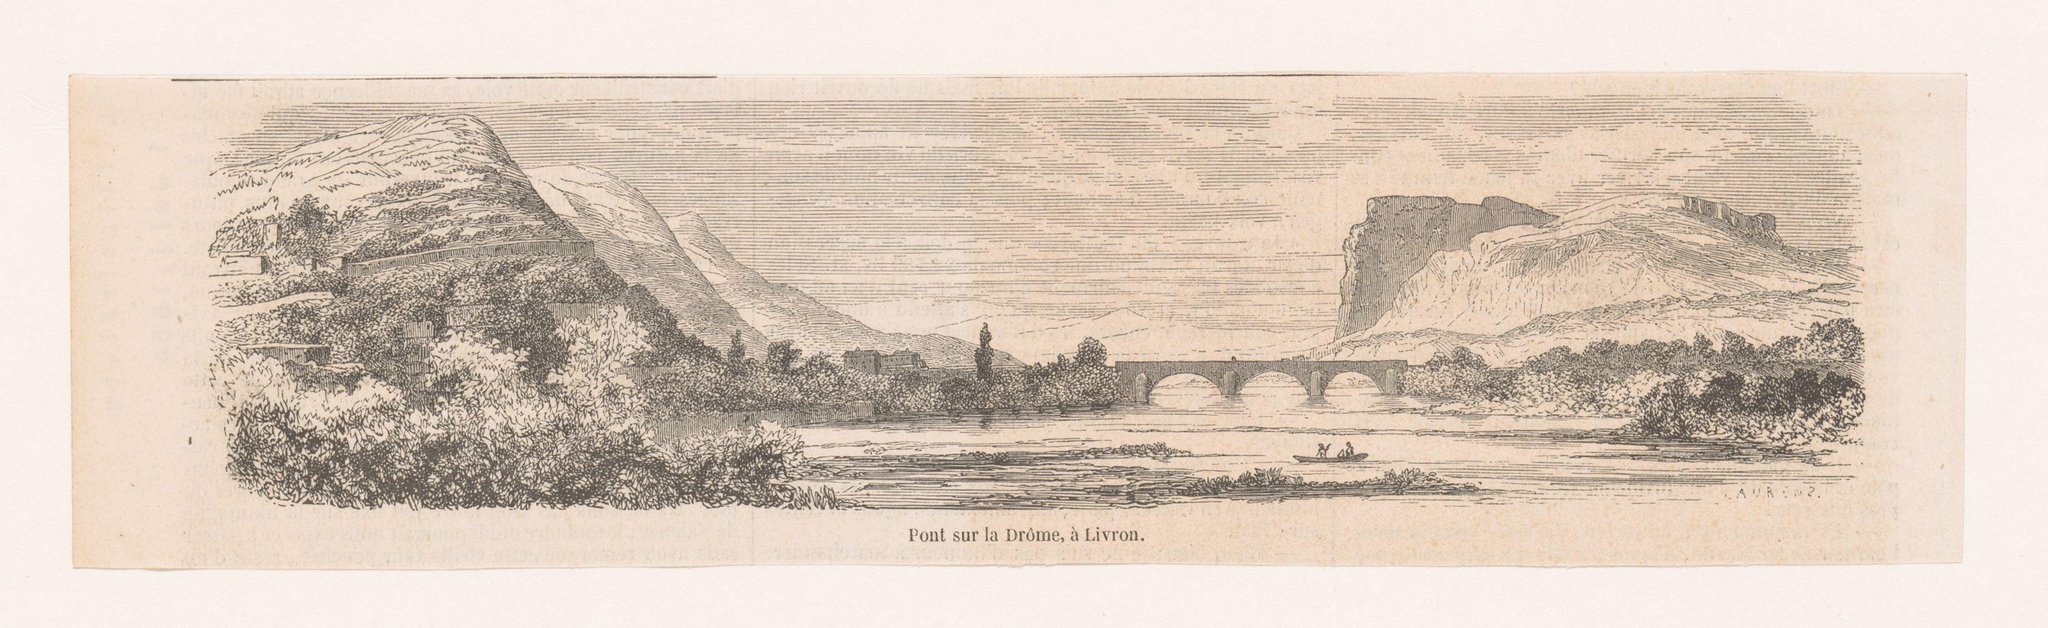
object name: print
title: Pont sur la Drôme, a Livron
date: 1854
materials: paper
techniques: letterpress printing, engraving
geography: paris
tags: landscape with bridge, viaduct or aqueduct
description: Prent uit: L'Illustration, vol. 25, nr. 592, 1 juli 1854, p. 12.